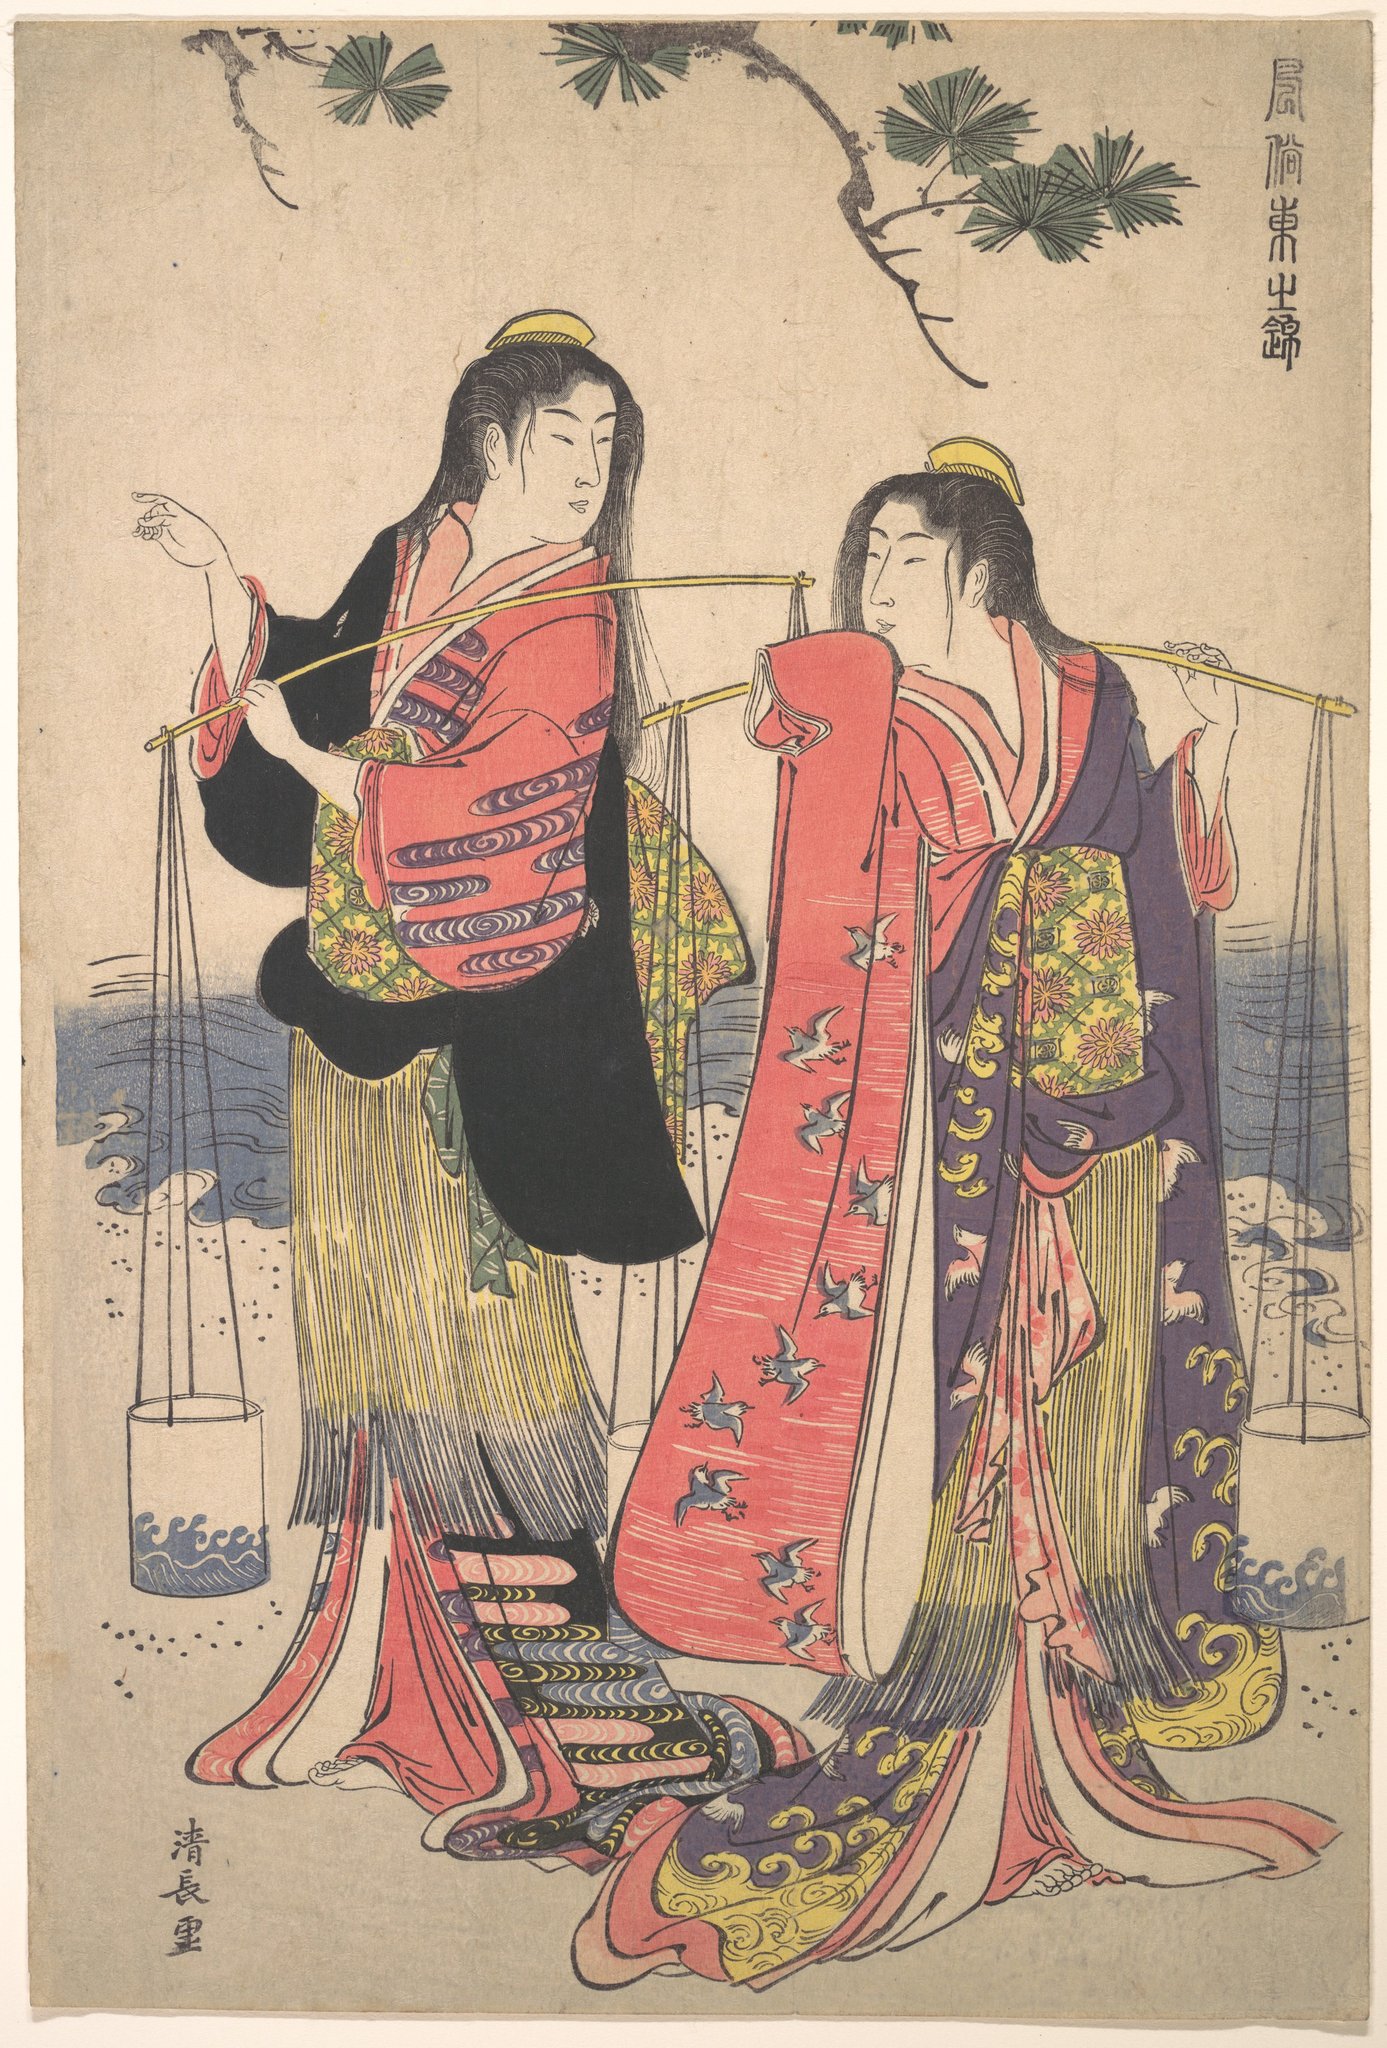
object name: print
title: The Salt Maidens Murusame and Matsukaze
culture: japanese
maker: torii kiyonaga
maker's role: artist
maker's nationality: japanese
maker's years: 1752-1815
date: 1786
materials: ink, paper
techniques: woodblock print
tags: women,leaves